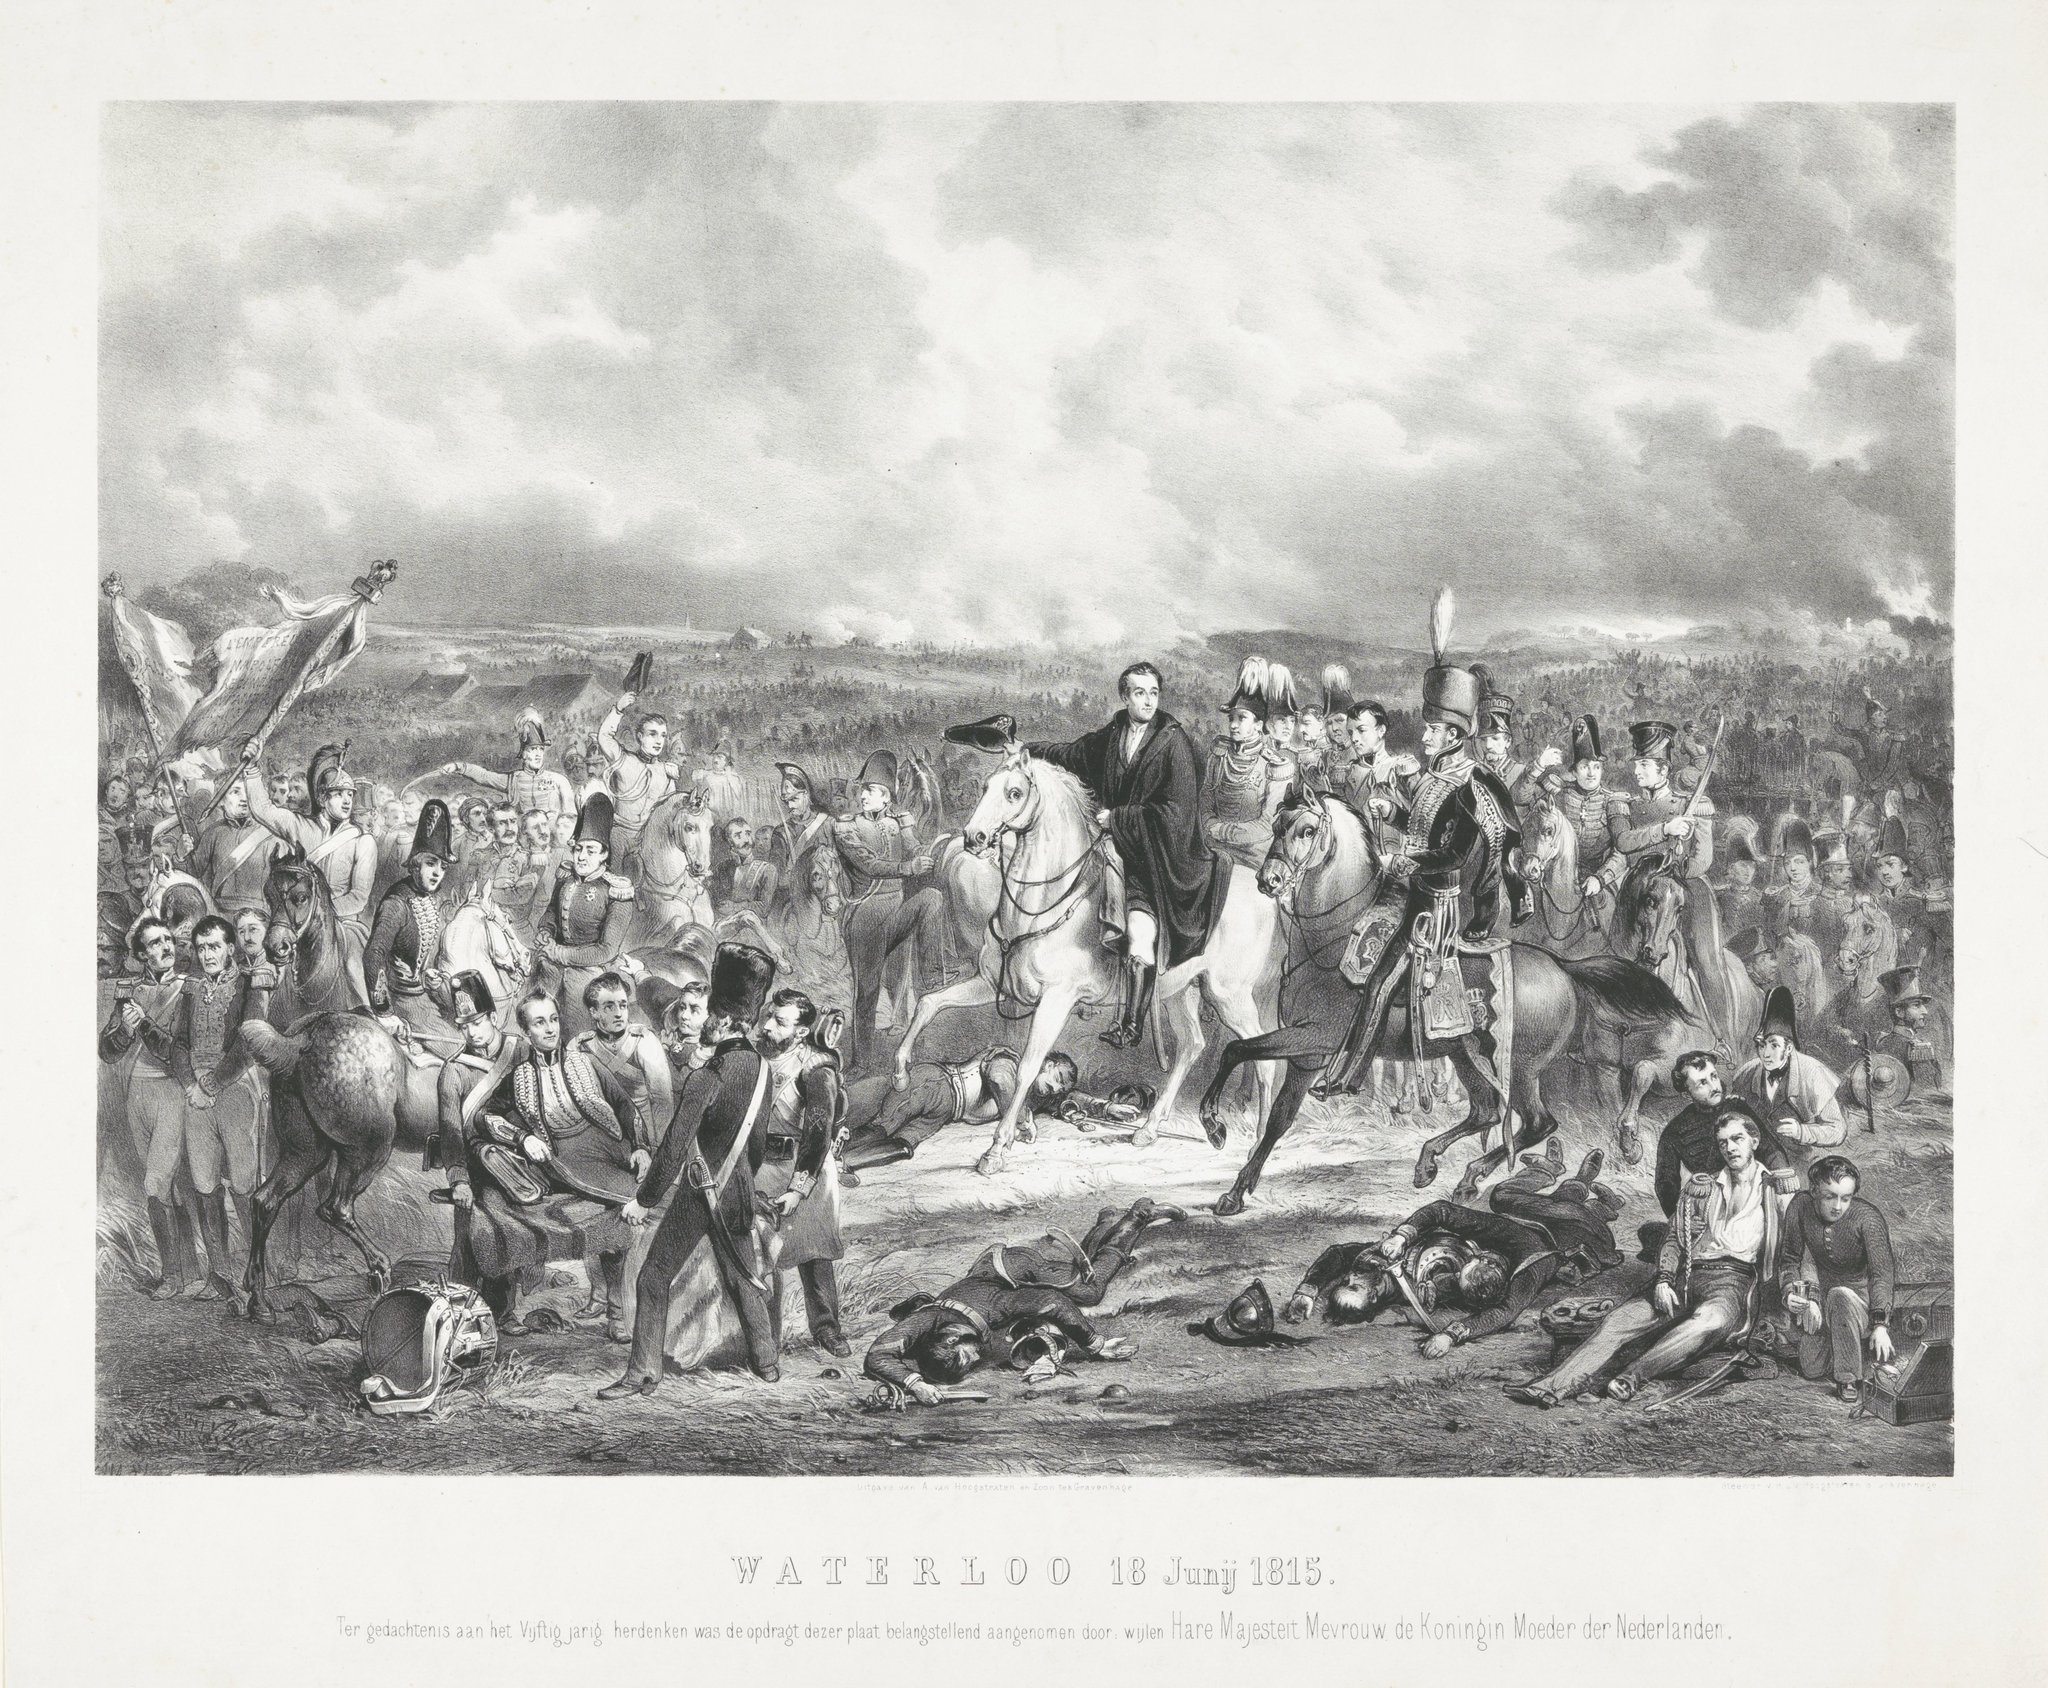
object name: print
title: Slag bij Waterloo, 1815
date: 1865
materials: paper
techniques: lithograph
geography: the hague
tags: the hague, william ii of the netherlands, walmer castle, arthur wellesley of wellington, battle (+ land forces), waterloo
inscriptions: collector's mark: Lugt 2228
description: De slag bij Waterloo, 18 juni 1815. Gezicht op het slagveld op het moment waarop de Engelse bevelhebber Wellington hoort dat Pruisische hulp onderweg is. De gewonde Willem, prins van Oranje, wordt links op de voorgrond weggevoerd. De bevelhebbers en andere officieren te paard staan in het midden, rechts op de voorgrond gewonde en dode soldaten. Op de achtergrond woeden de gevechten op het slagveld. Vervaardigd ter gelegenheid van het vijftigjarige jublieum van de slag in 1865.